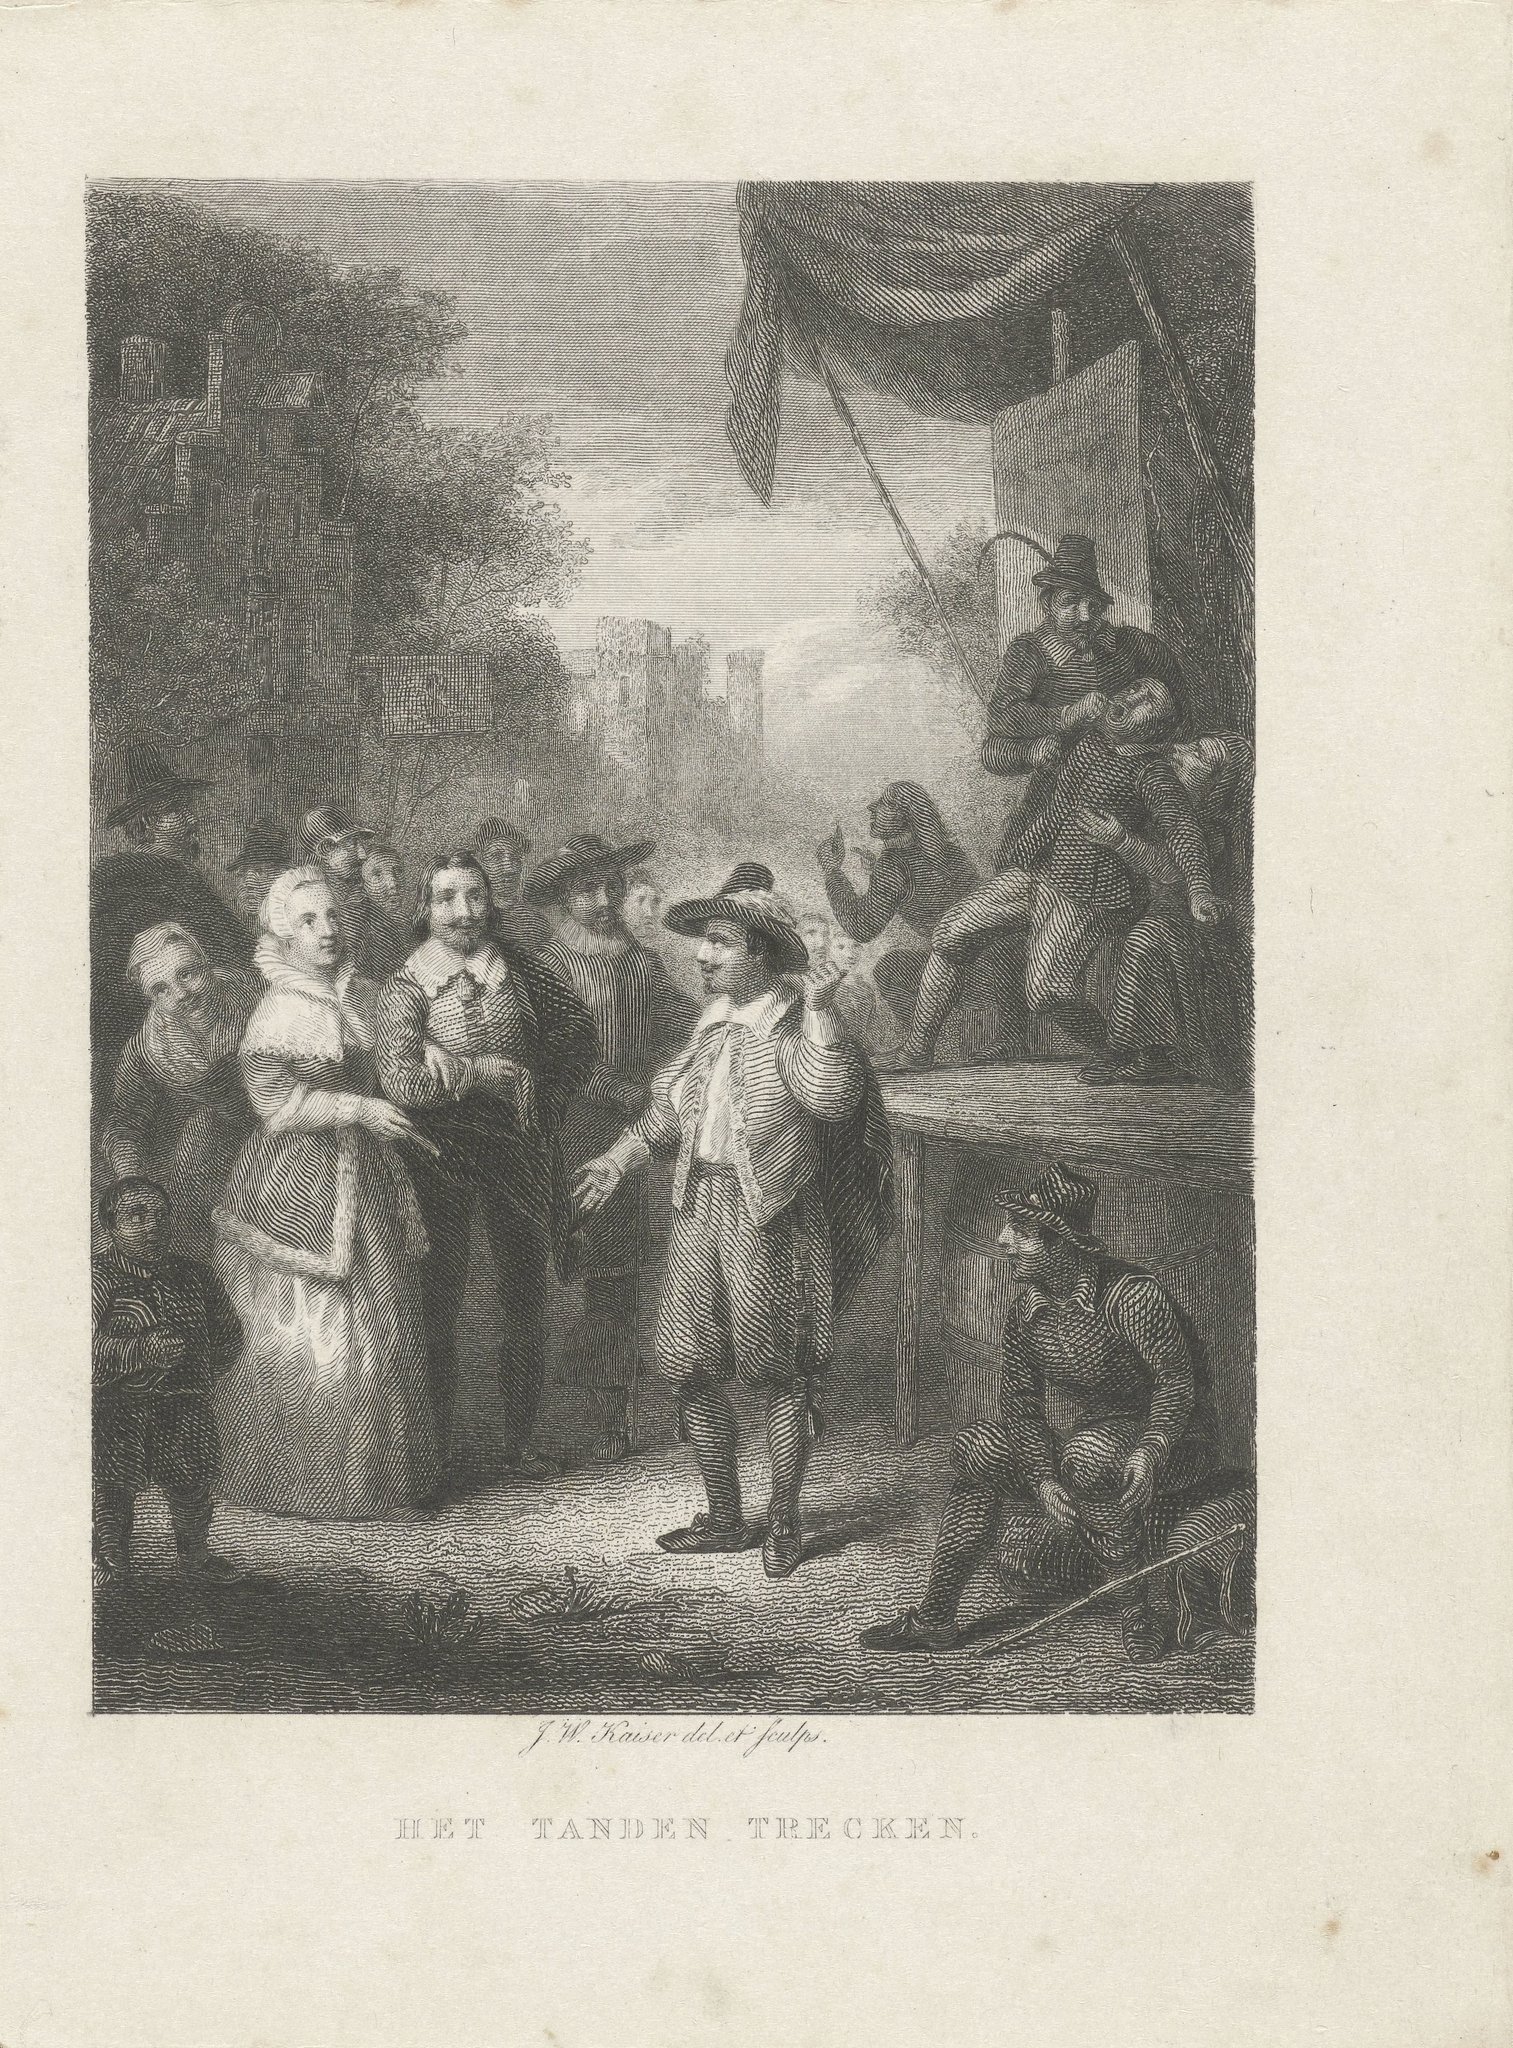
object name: print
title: Tandentrekker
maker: johann wilhelm kaiser (i)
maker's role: draughtsman, print maker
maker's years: 1813-1900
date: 1839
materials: paper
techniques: etching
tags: quack extracting teeth or molars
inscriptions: inscription: ‘uit Tesselschade 1839’, collector's mark: Lugt 2228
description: Aan de rand van een stad staat een podium waarbij een groep mensen. Op het podium bevindt zich onder andere een patiënt met geopende mond die zich een kies laat trekken, terwijl hij door een vrouw wordt vastgehouden.